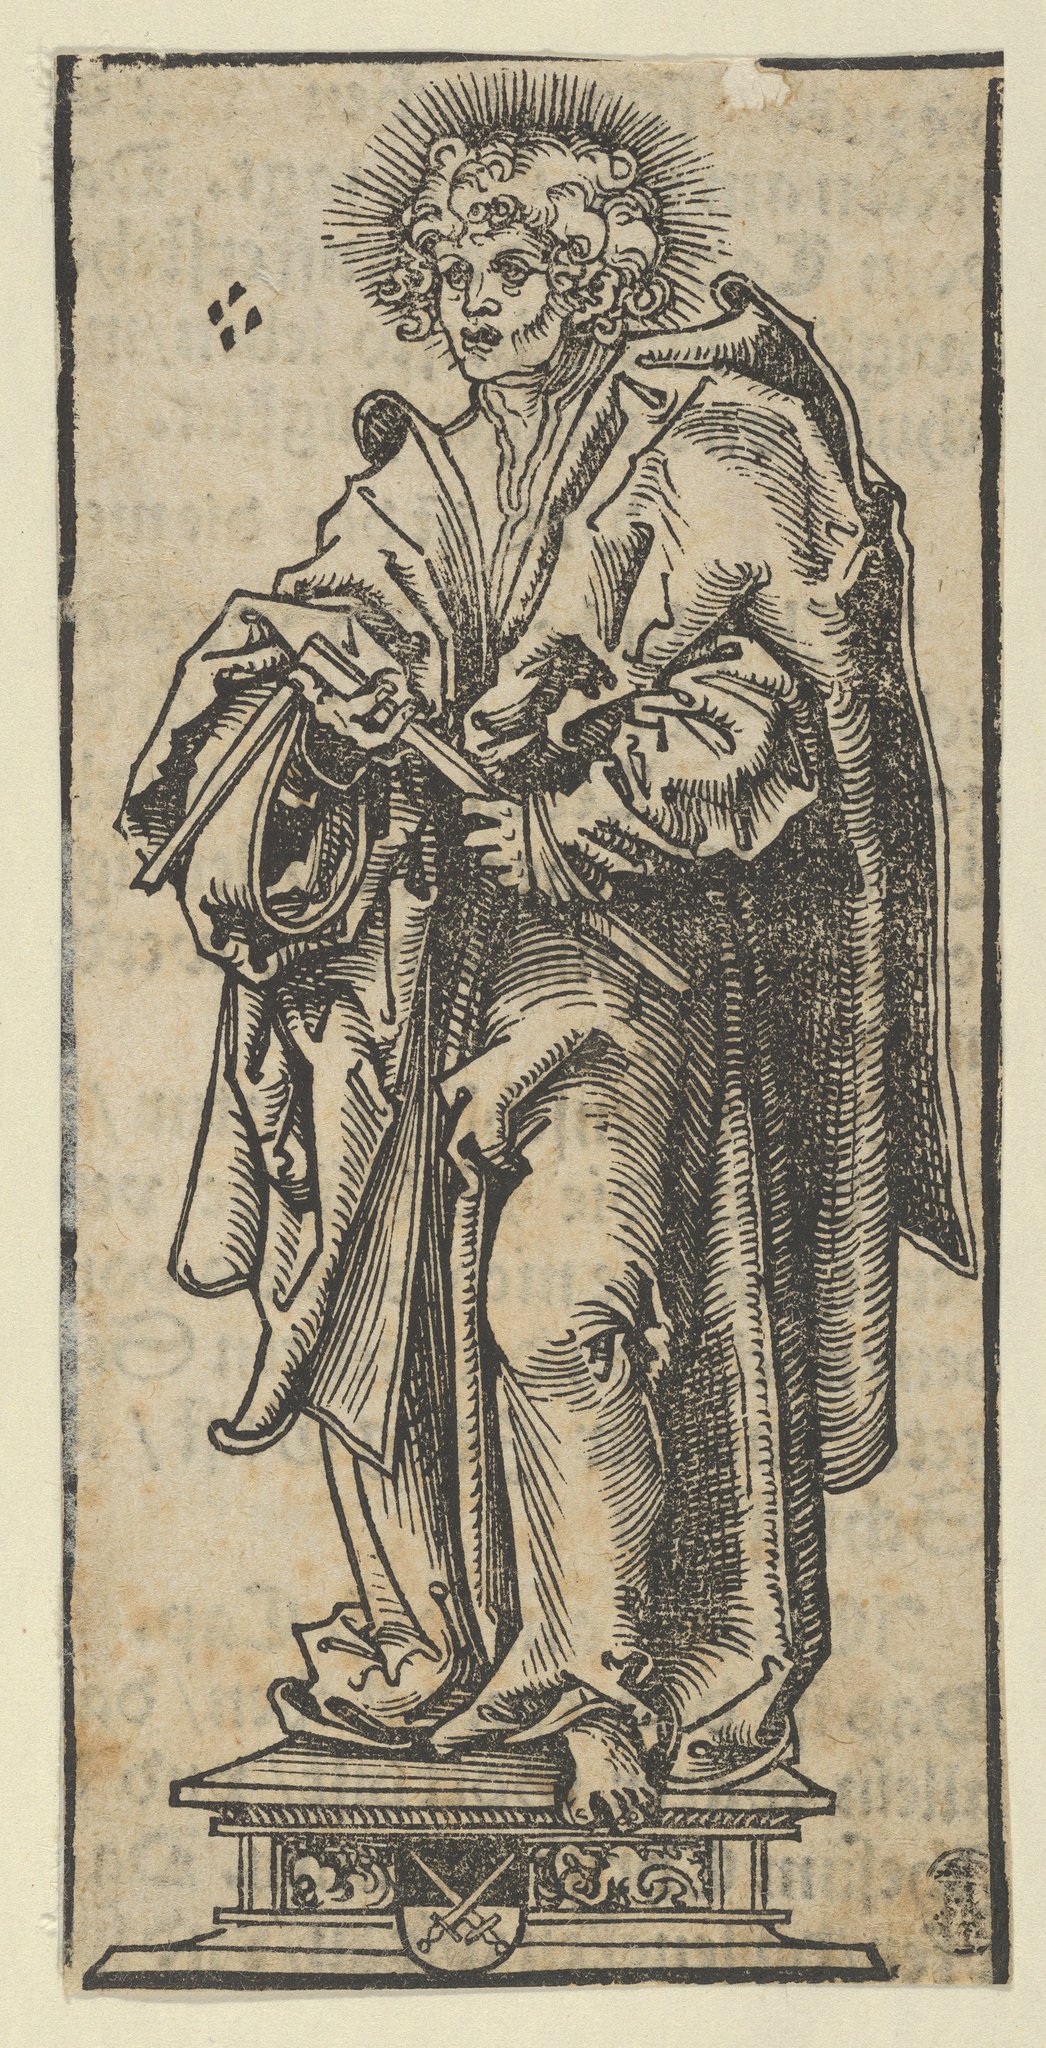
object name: print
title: Silver Statuette of St. Matthias, from the "Wittenberg Reliquaries"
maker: lucas cranach the elder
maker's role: artist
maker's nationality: german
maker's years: 1472-1553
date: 1472-1553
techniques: woodcut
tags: reliquaries,saints